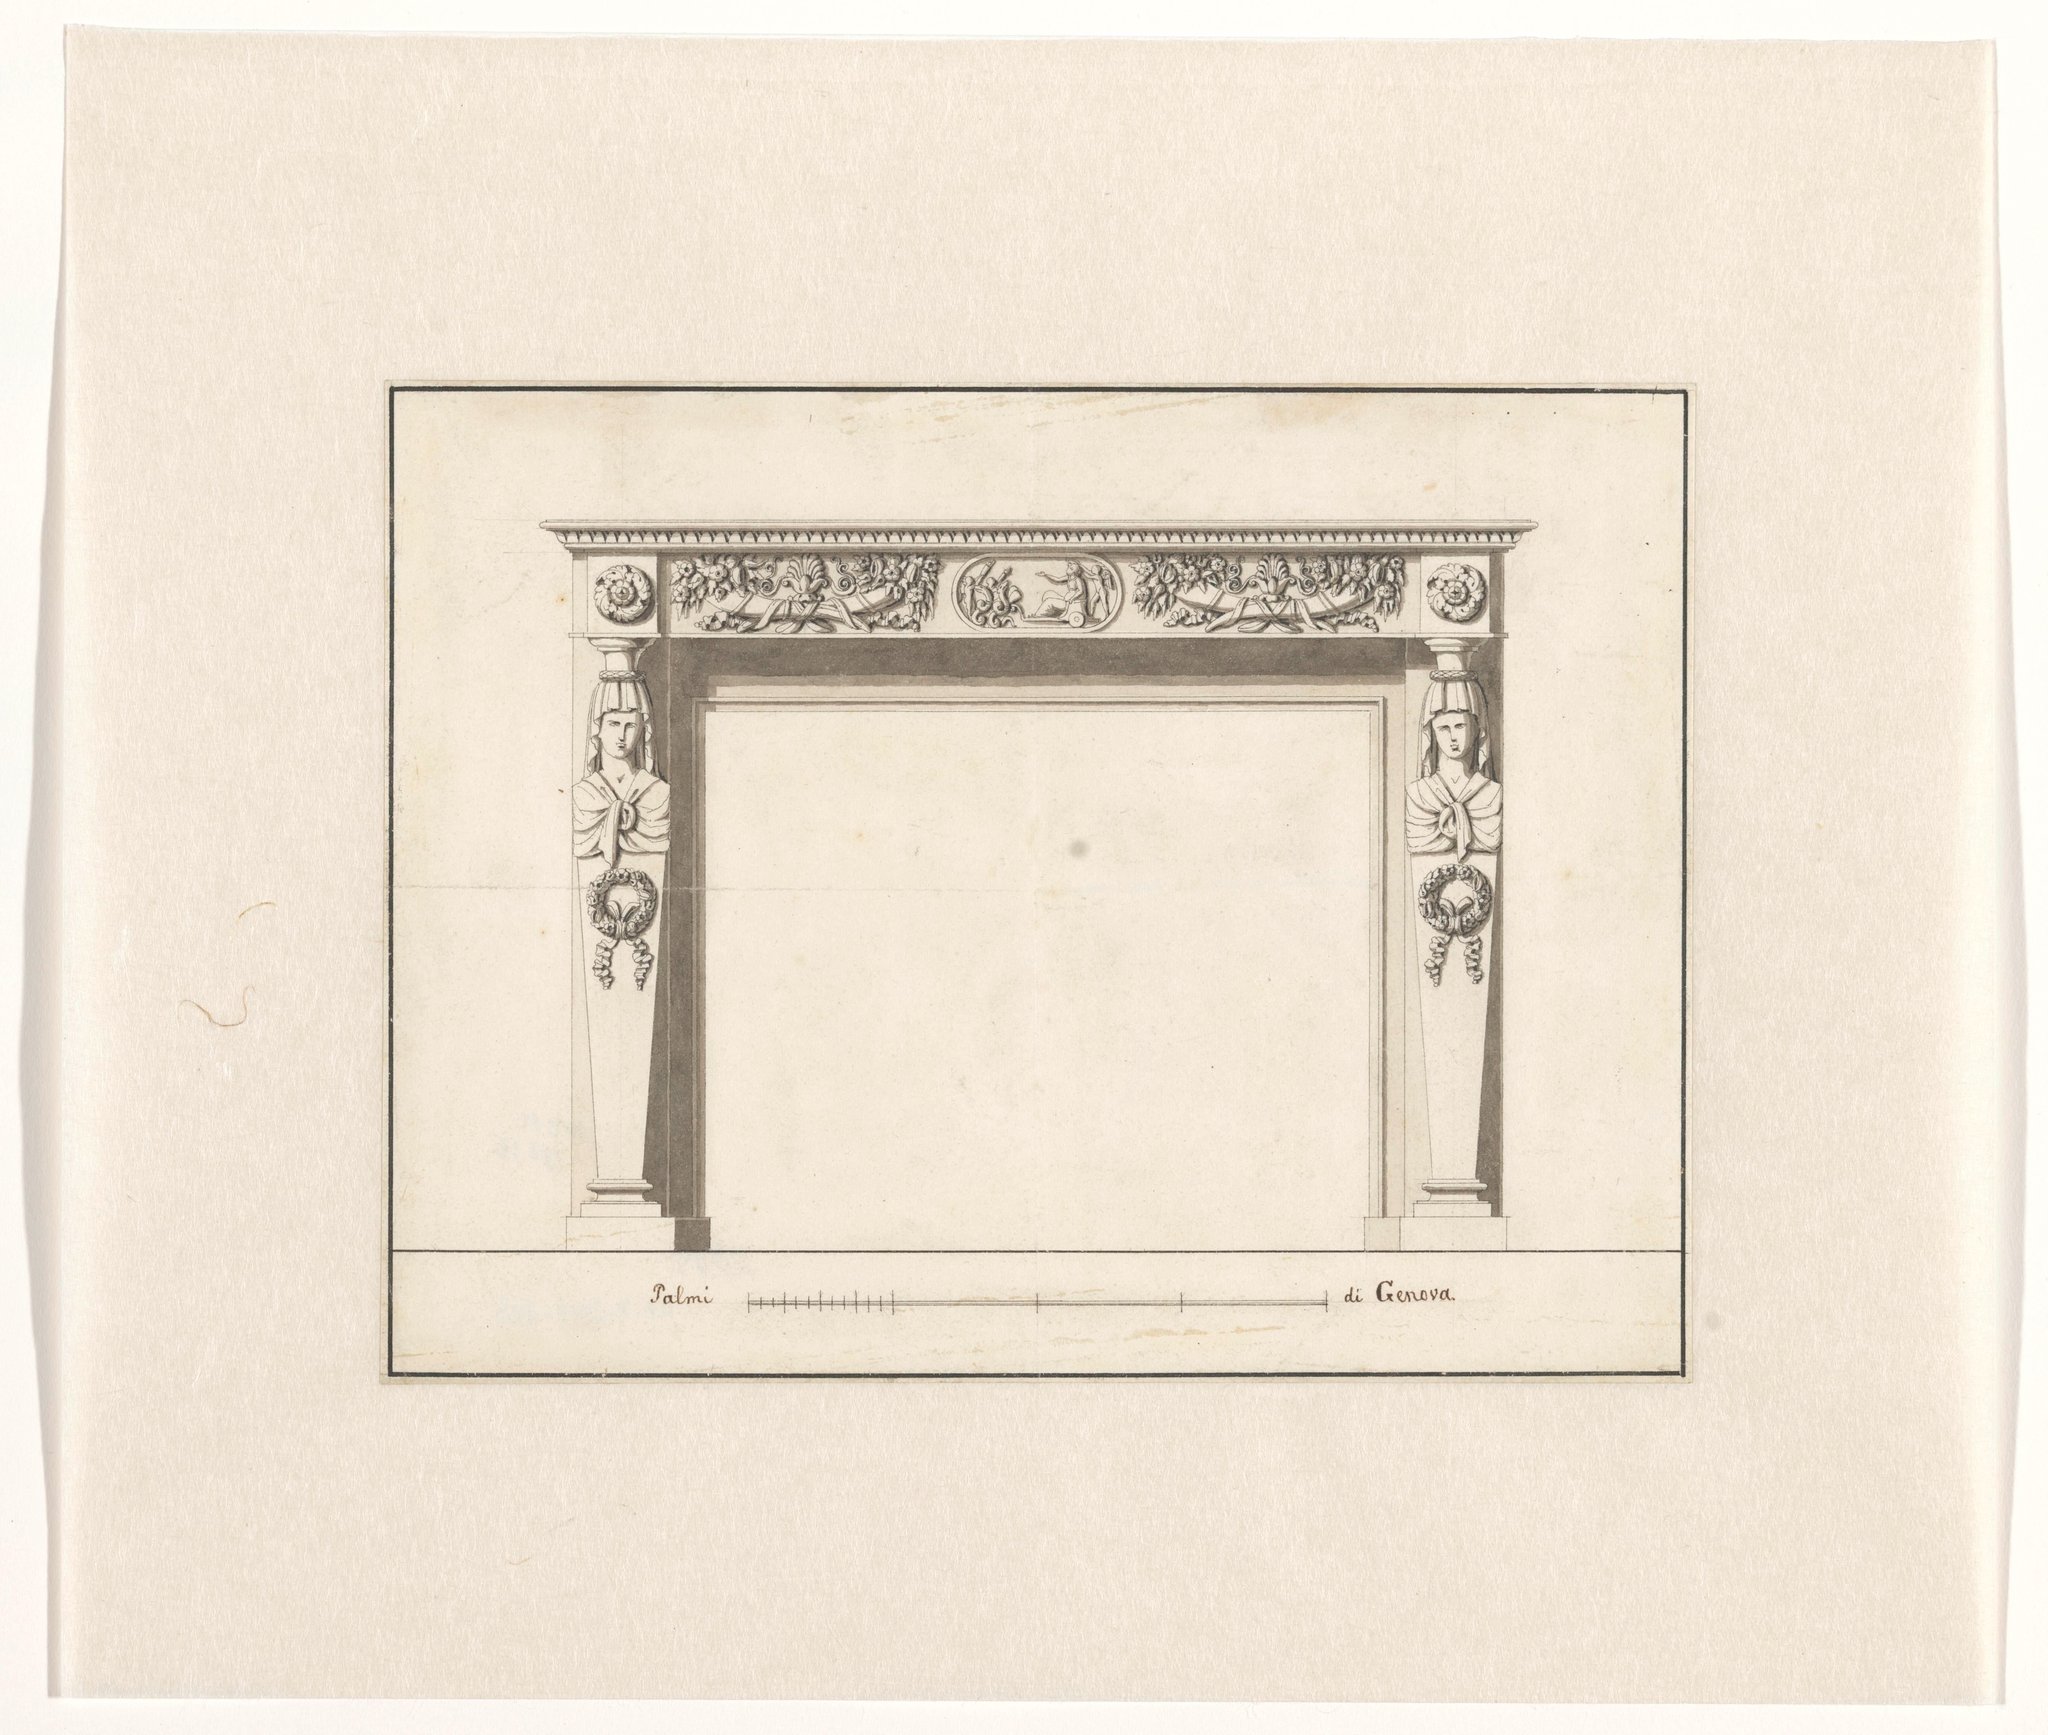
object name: drawing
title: Schoorsteen met vrouwelijke hermfiguren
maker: genua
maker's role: draughtsman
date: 1810-1830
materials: ink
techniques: brush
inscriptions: size: ‘Palmi di Genova’